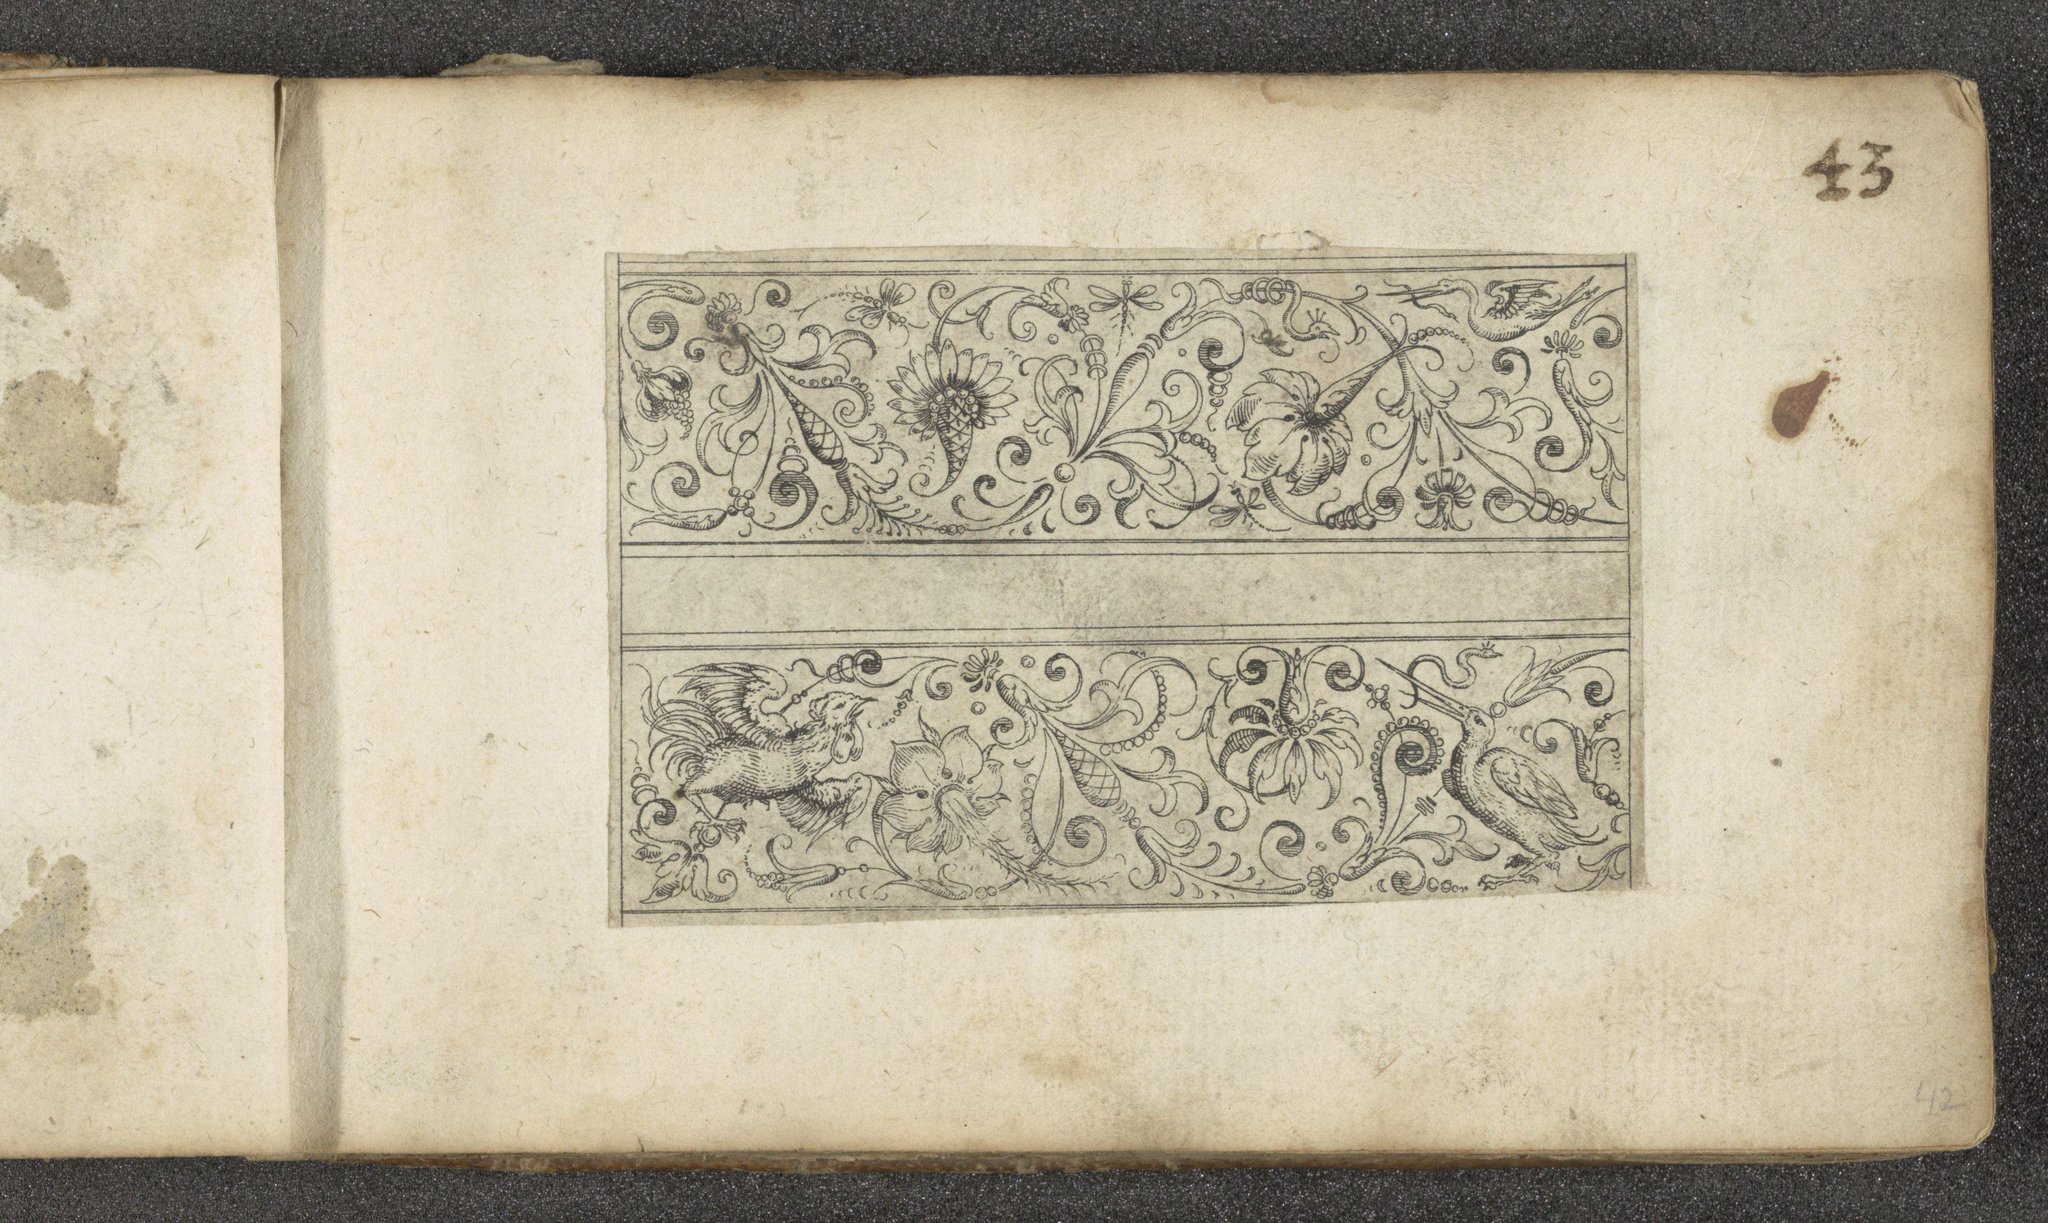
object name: print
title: Twee friezen met vogels en insecten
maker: Anonymous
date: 1551-1650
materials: paper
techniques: etching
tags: ornaments ~ art, birds, insects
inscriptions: inscription: ‘43’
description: Twee friezen boven elkaar. Beide ornamenten met vogels en insecten. Daarbij enkele bloemen. De prent maakt deel uit van een album.